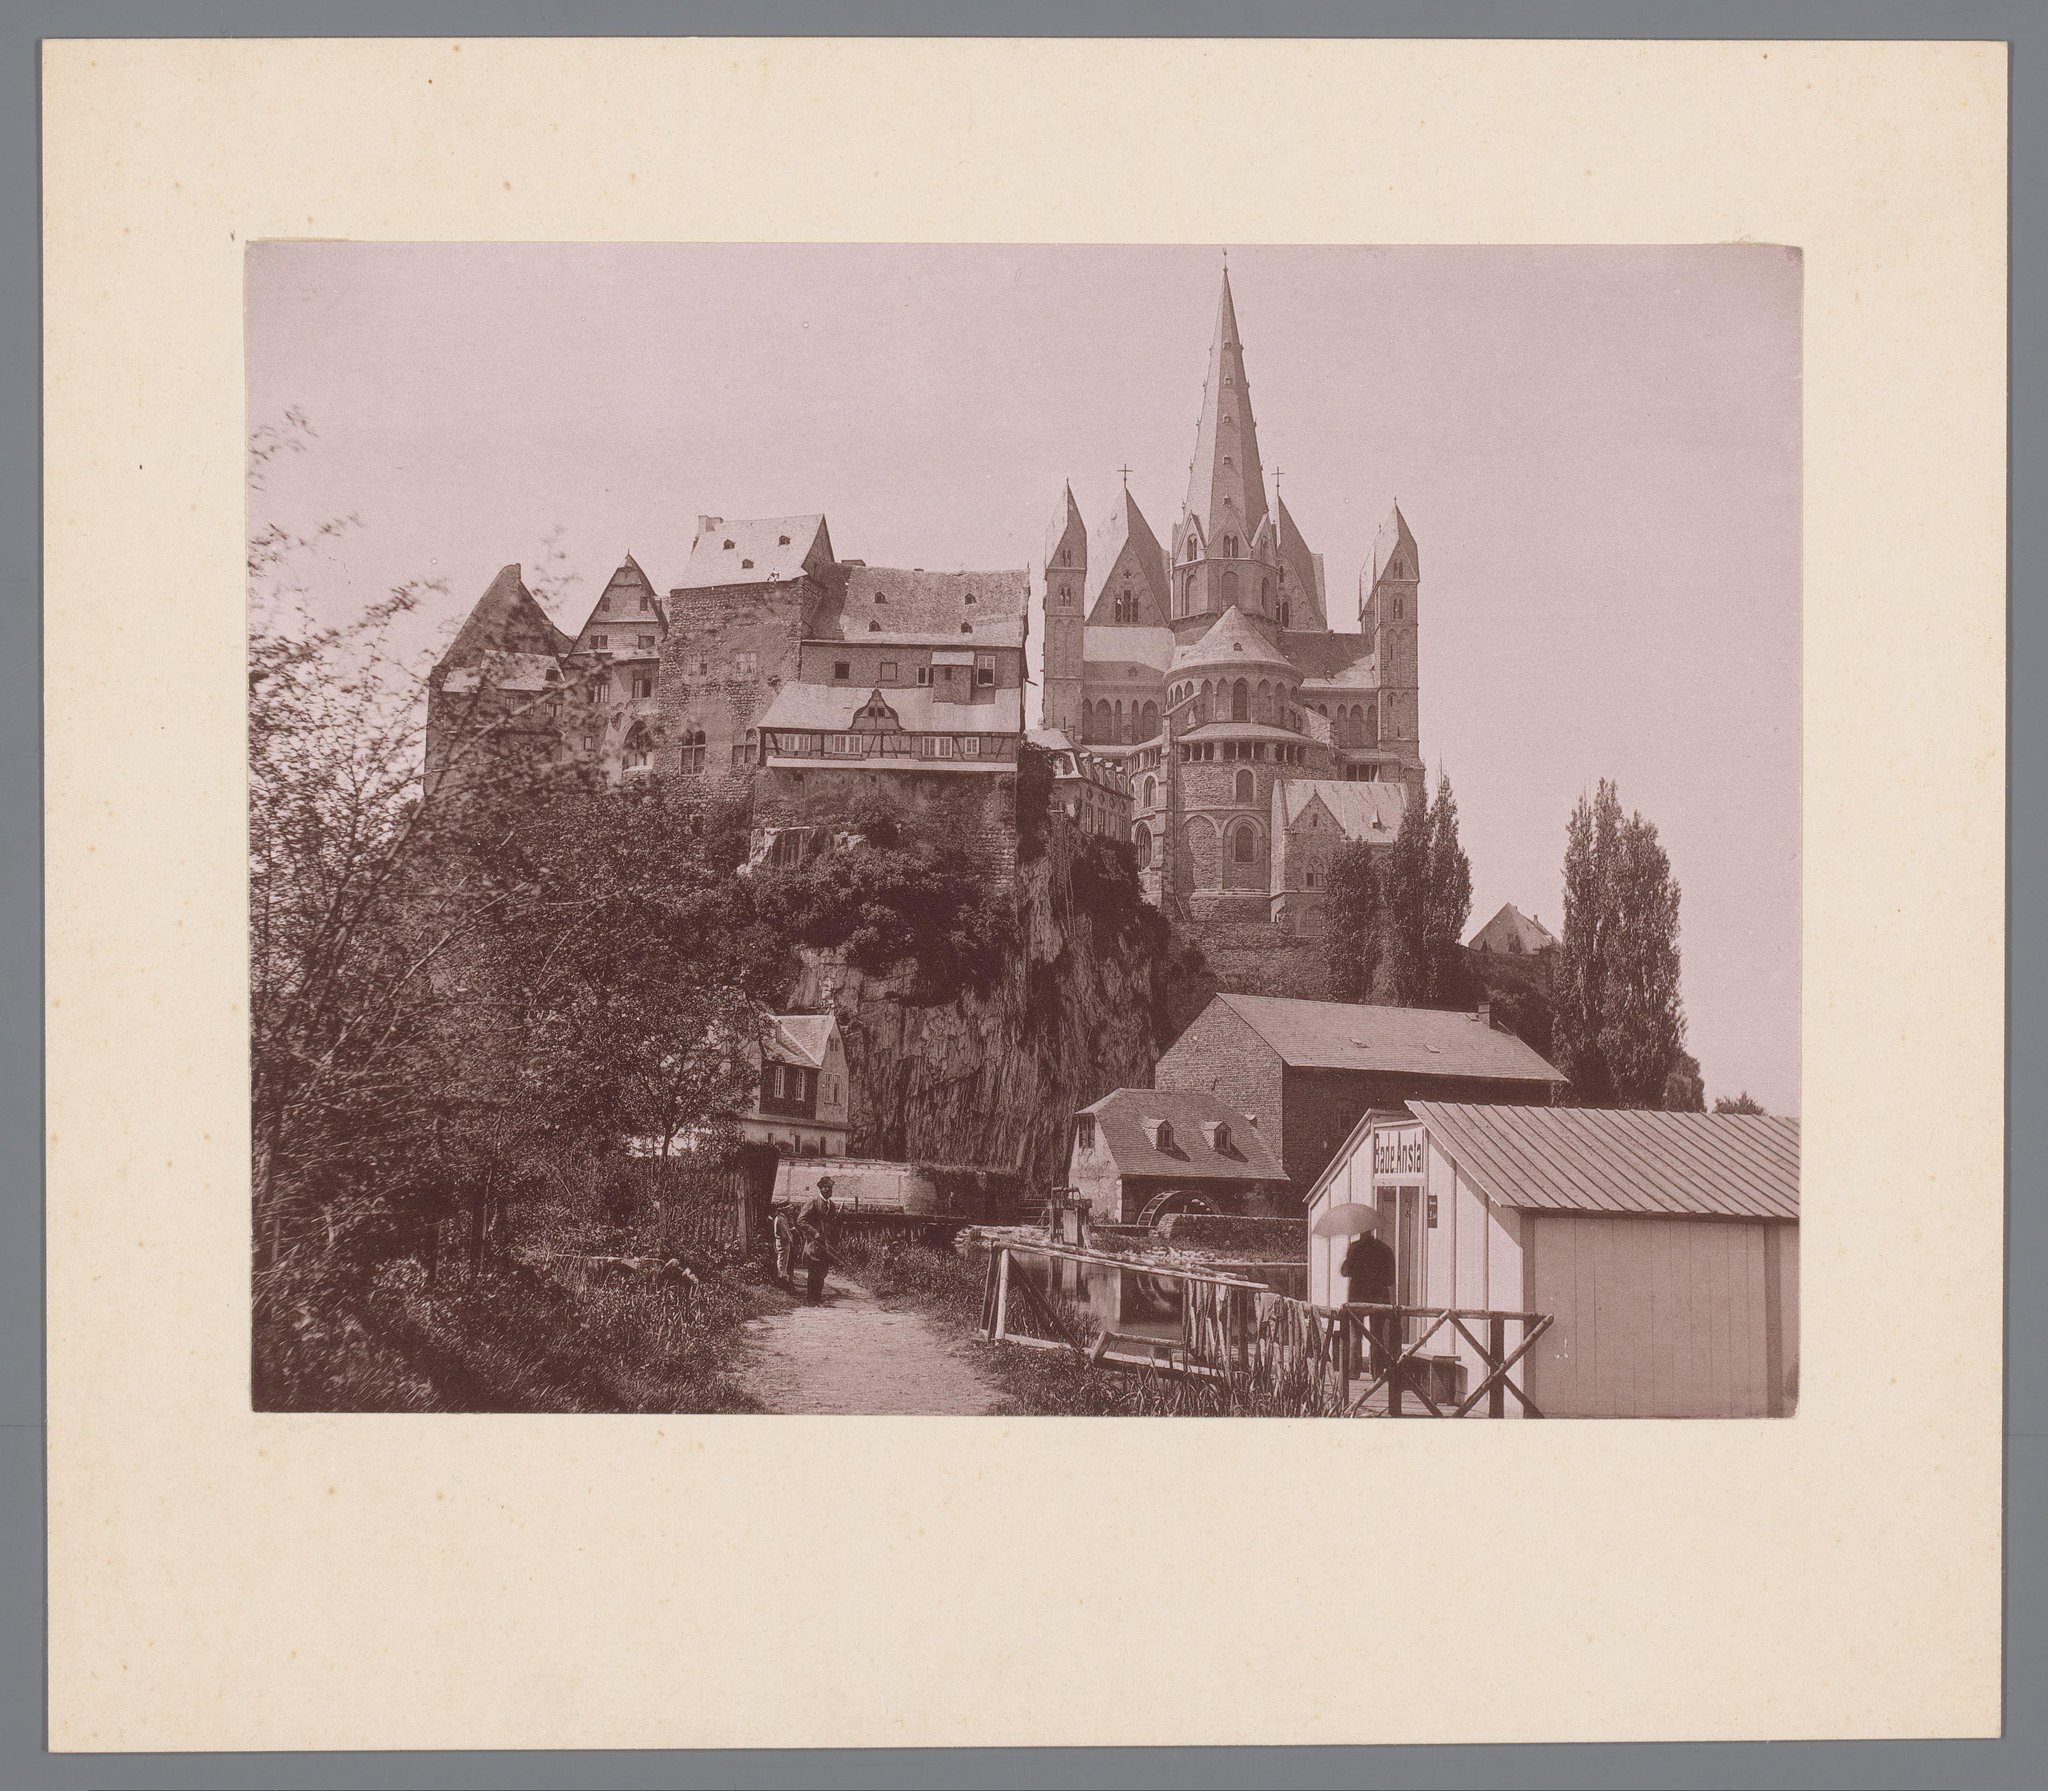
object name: photomechanical print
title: Dom van Limburg in Limburg an der Lahn, Duitsland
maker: Anonymous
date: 1870-1930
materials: cardboard, paper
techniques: photograph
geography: limburg an der lahn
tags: church (exterior)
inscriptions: inscription: ‘Dom te Limburg/ aan de Lahn ± 1235’